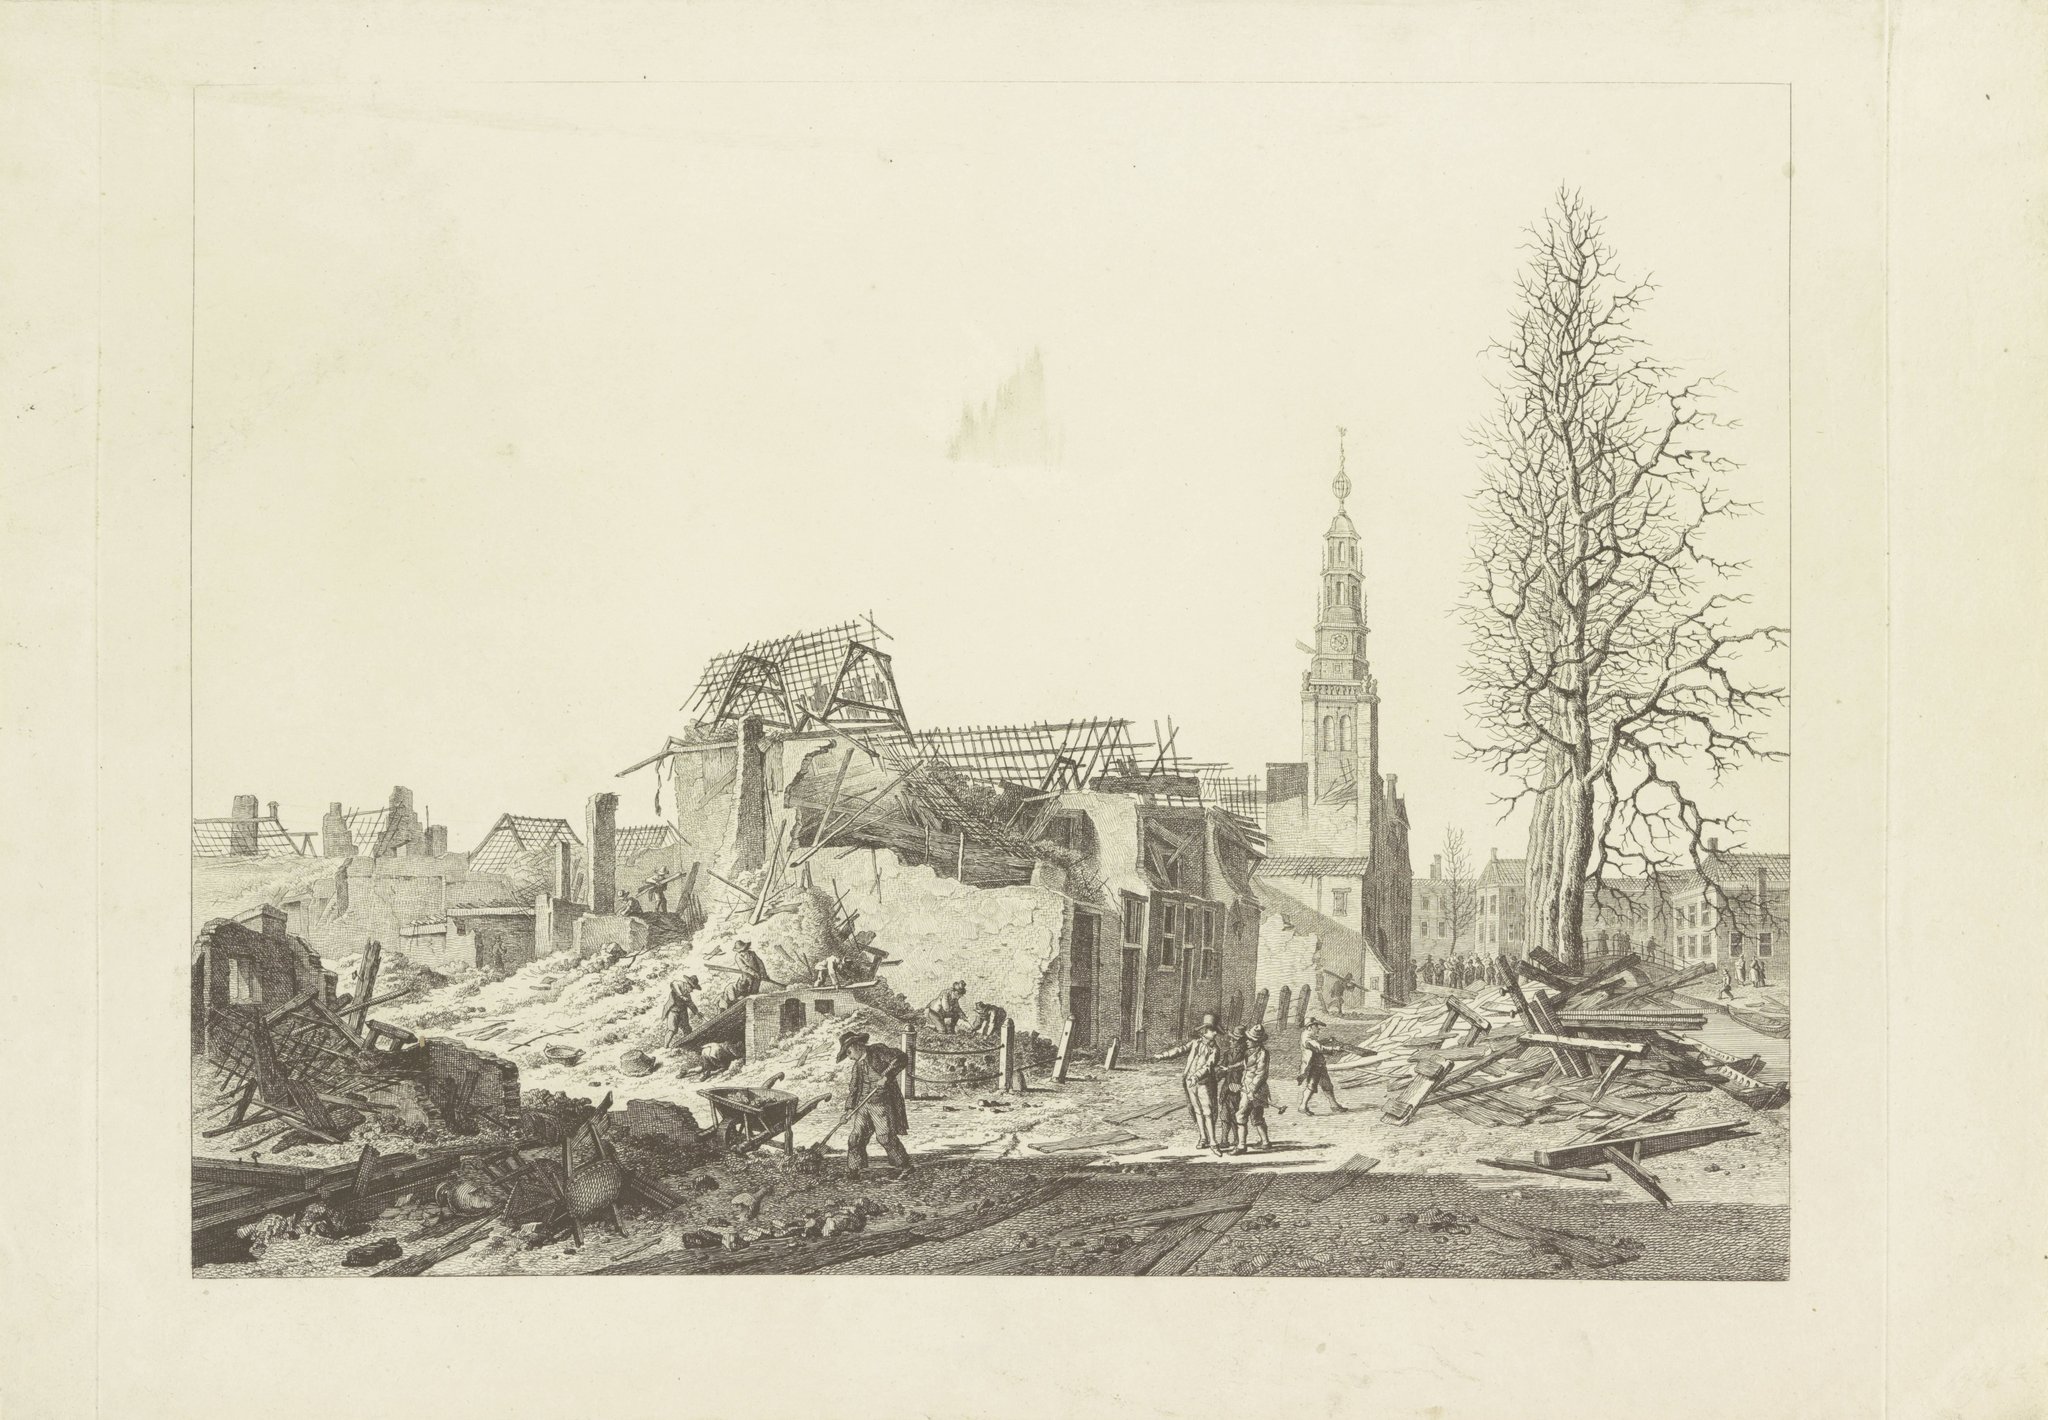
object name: print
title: Ruïnes op het Steenschuur (noordzijde) na de Leidse buskruitramp, 1807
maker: leendert overbeek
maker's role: draughtsman, painter, print maker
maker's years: 1752-1815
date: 1807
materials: paper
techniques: etching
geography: leiden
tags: gunpowder disaster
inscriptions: collector's mark: Lugt 2228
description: Opruimwerkzaamheden bij de verwoeste gebouwen aan de noordzijde van het Steenschuur te Leiden na de buskruitramp op 12 januari 1807, middenrechts de Saaihal. Zie ook de pendant.